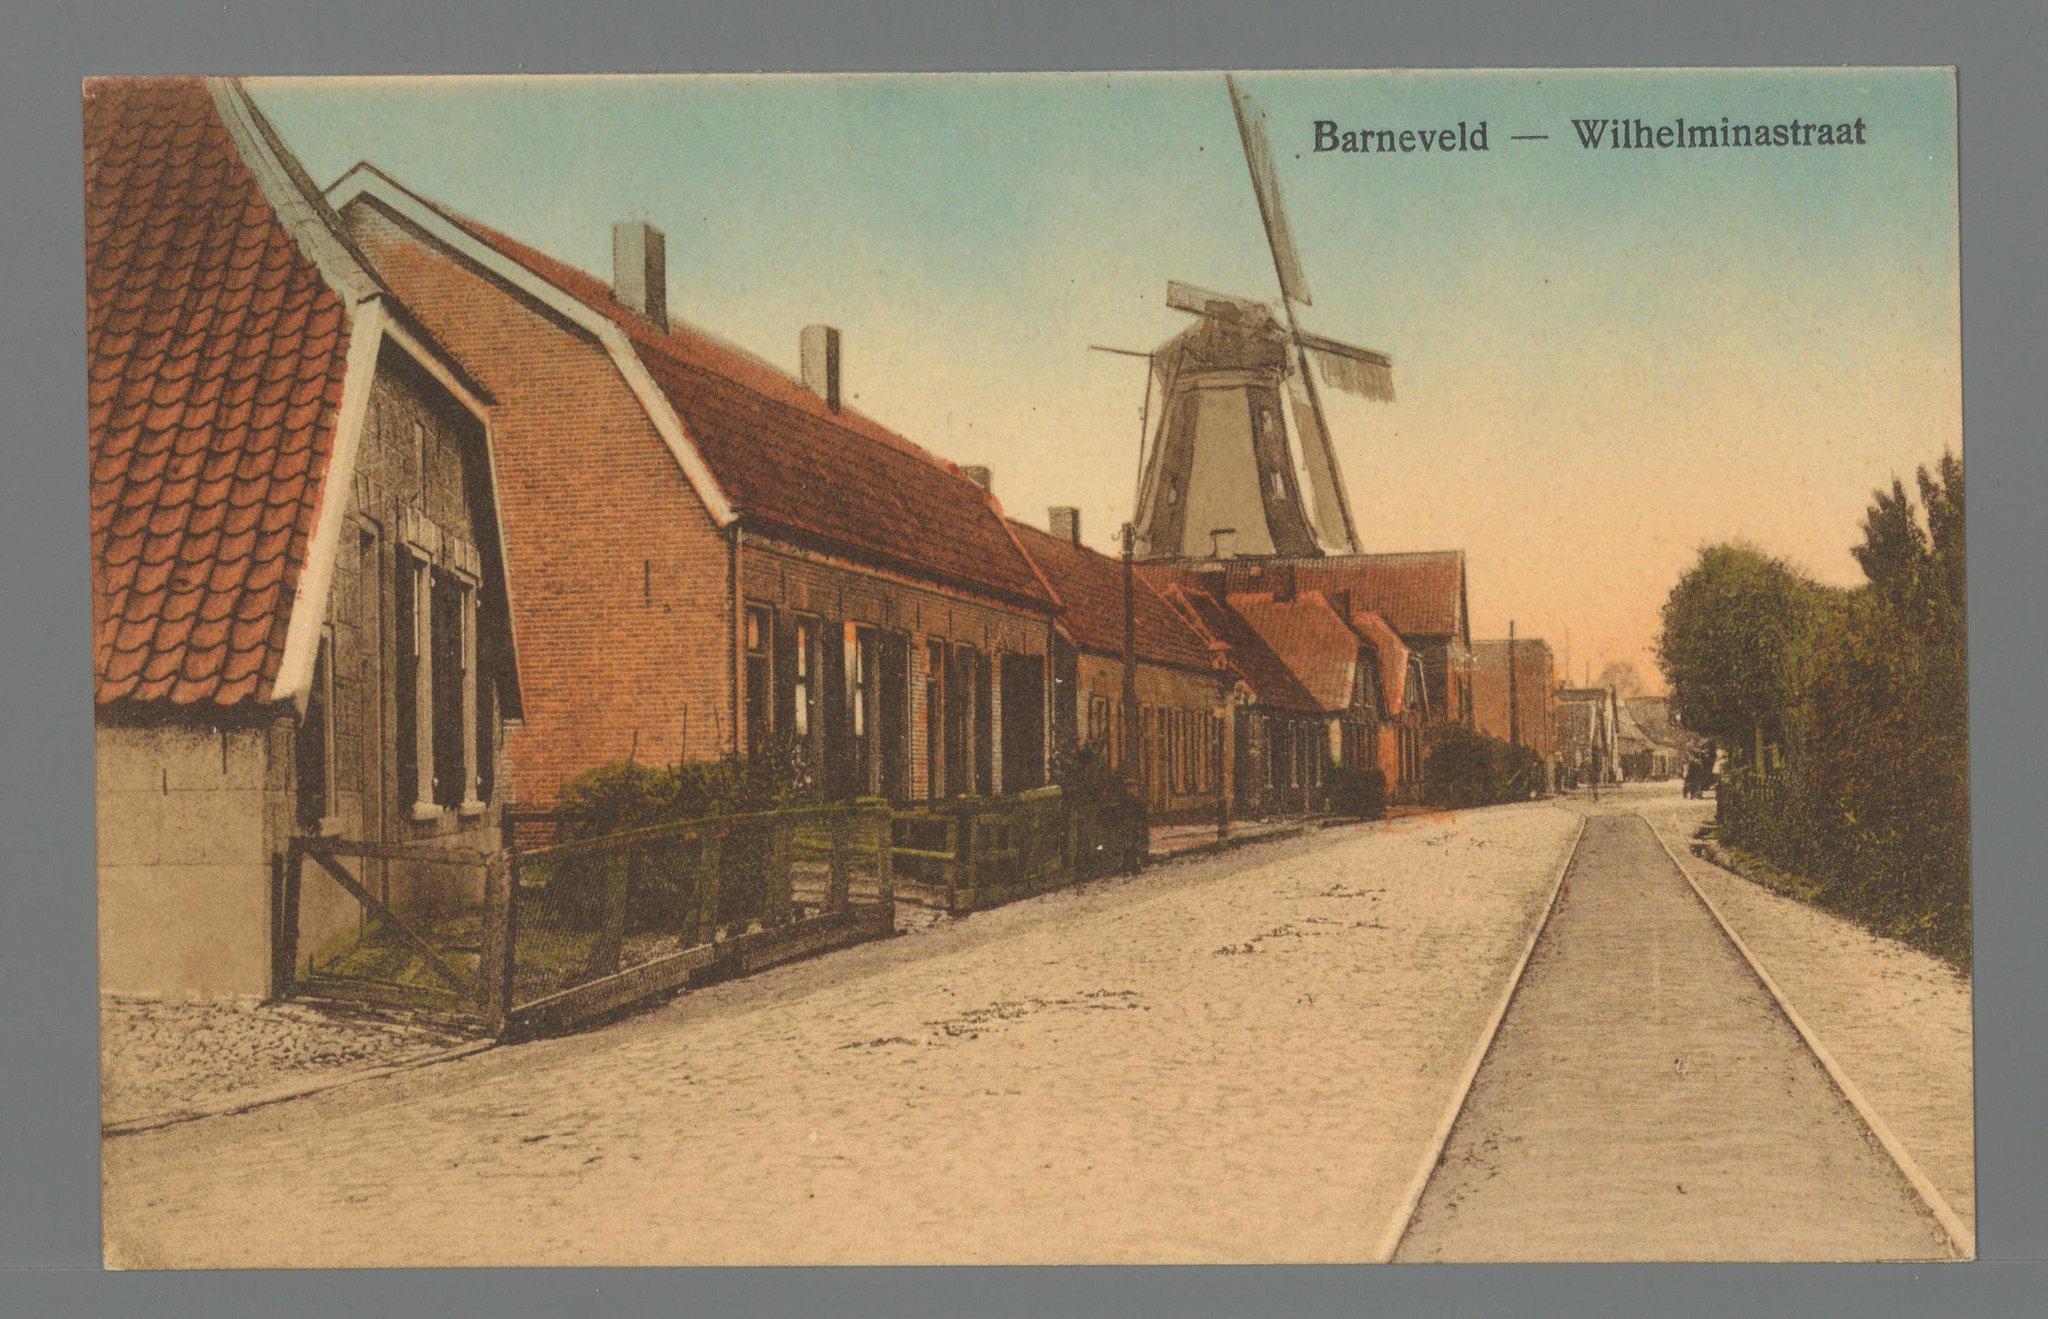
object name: photomechanical print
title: Barneveld - Wilhelminastraat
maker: Anonymous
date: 1905-1930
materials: cardboard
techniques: photograph, lithograph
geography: barneveld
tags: windmill, street